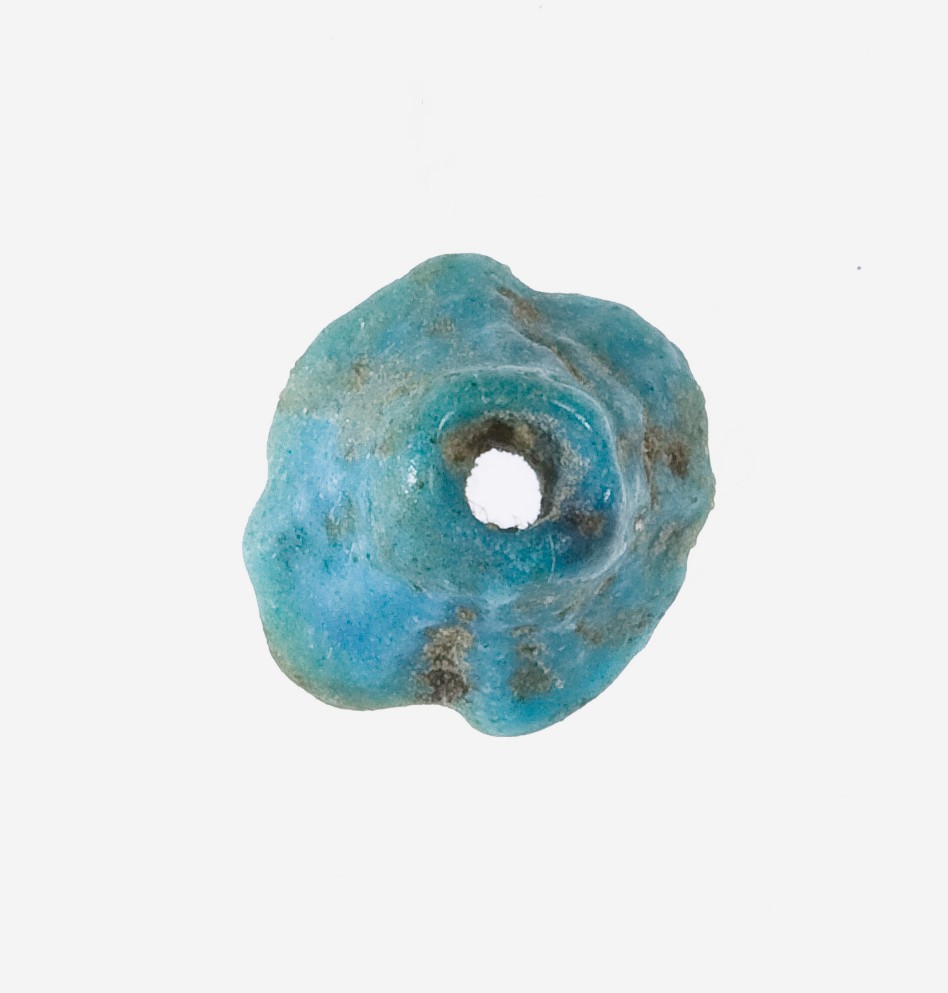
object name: pendant, cornflower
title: Pendant: Petals of Cornflower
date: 1390-1352 BCE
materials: faience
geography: egypt